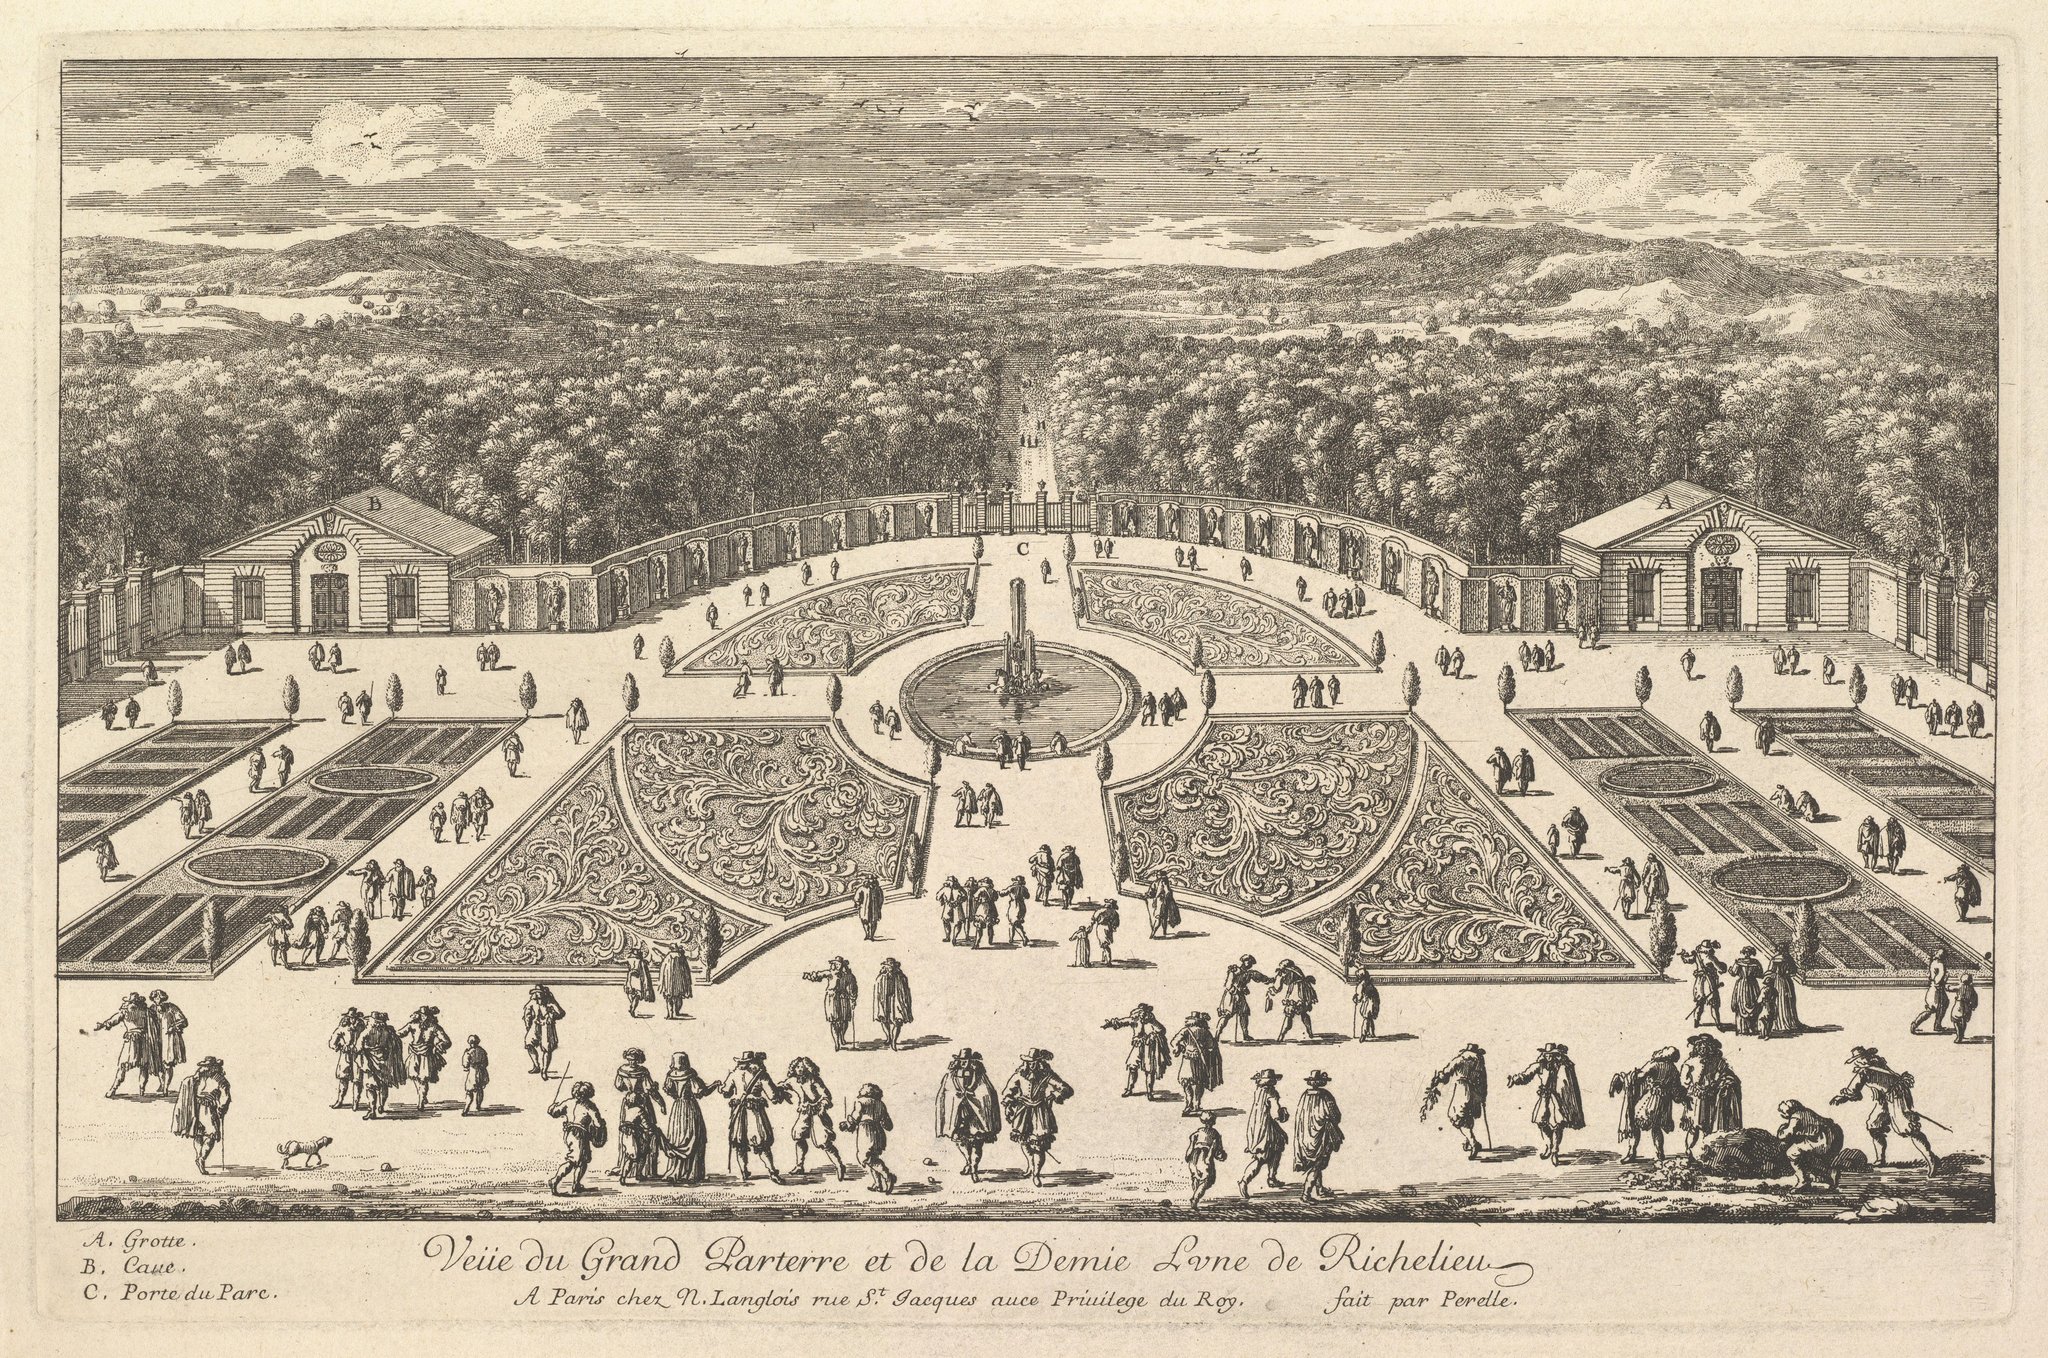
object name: print ornament architecture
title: Veüe du Grand Parterre et de la Demie Lune de Richelieu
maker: adam perelle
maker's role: artist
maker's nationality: french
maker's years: 1640-1695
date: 1601-1700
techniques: etching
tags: courtyards,men,trees